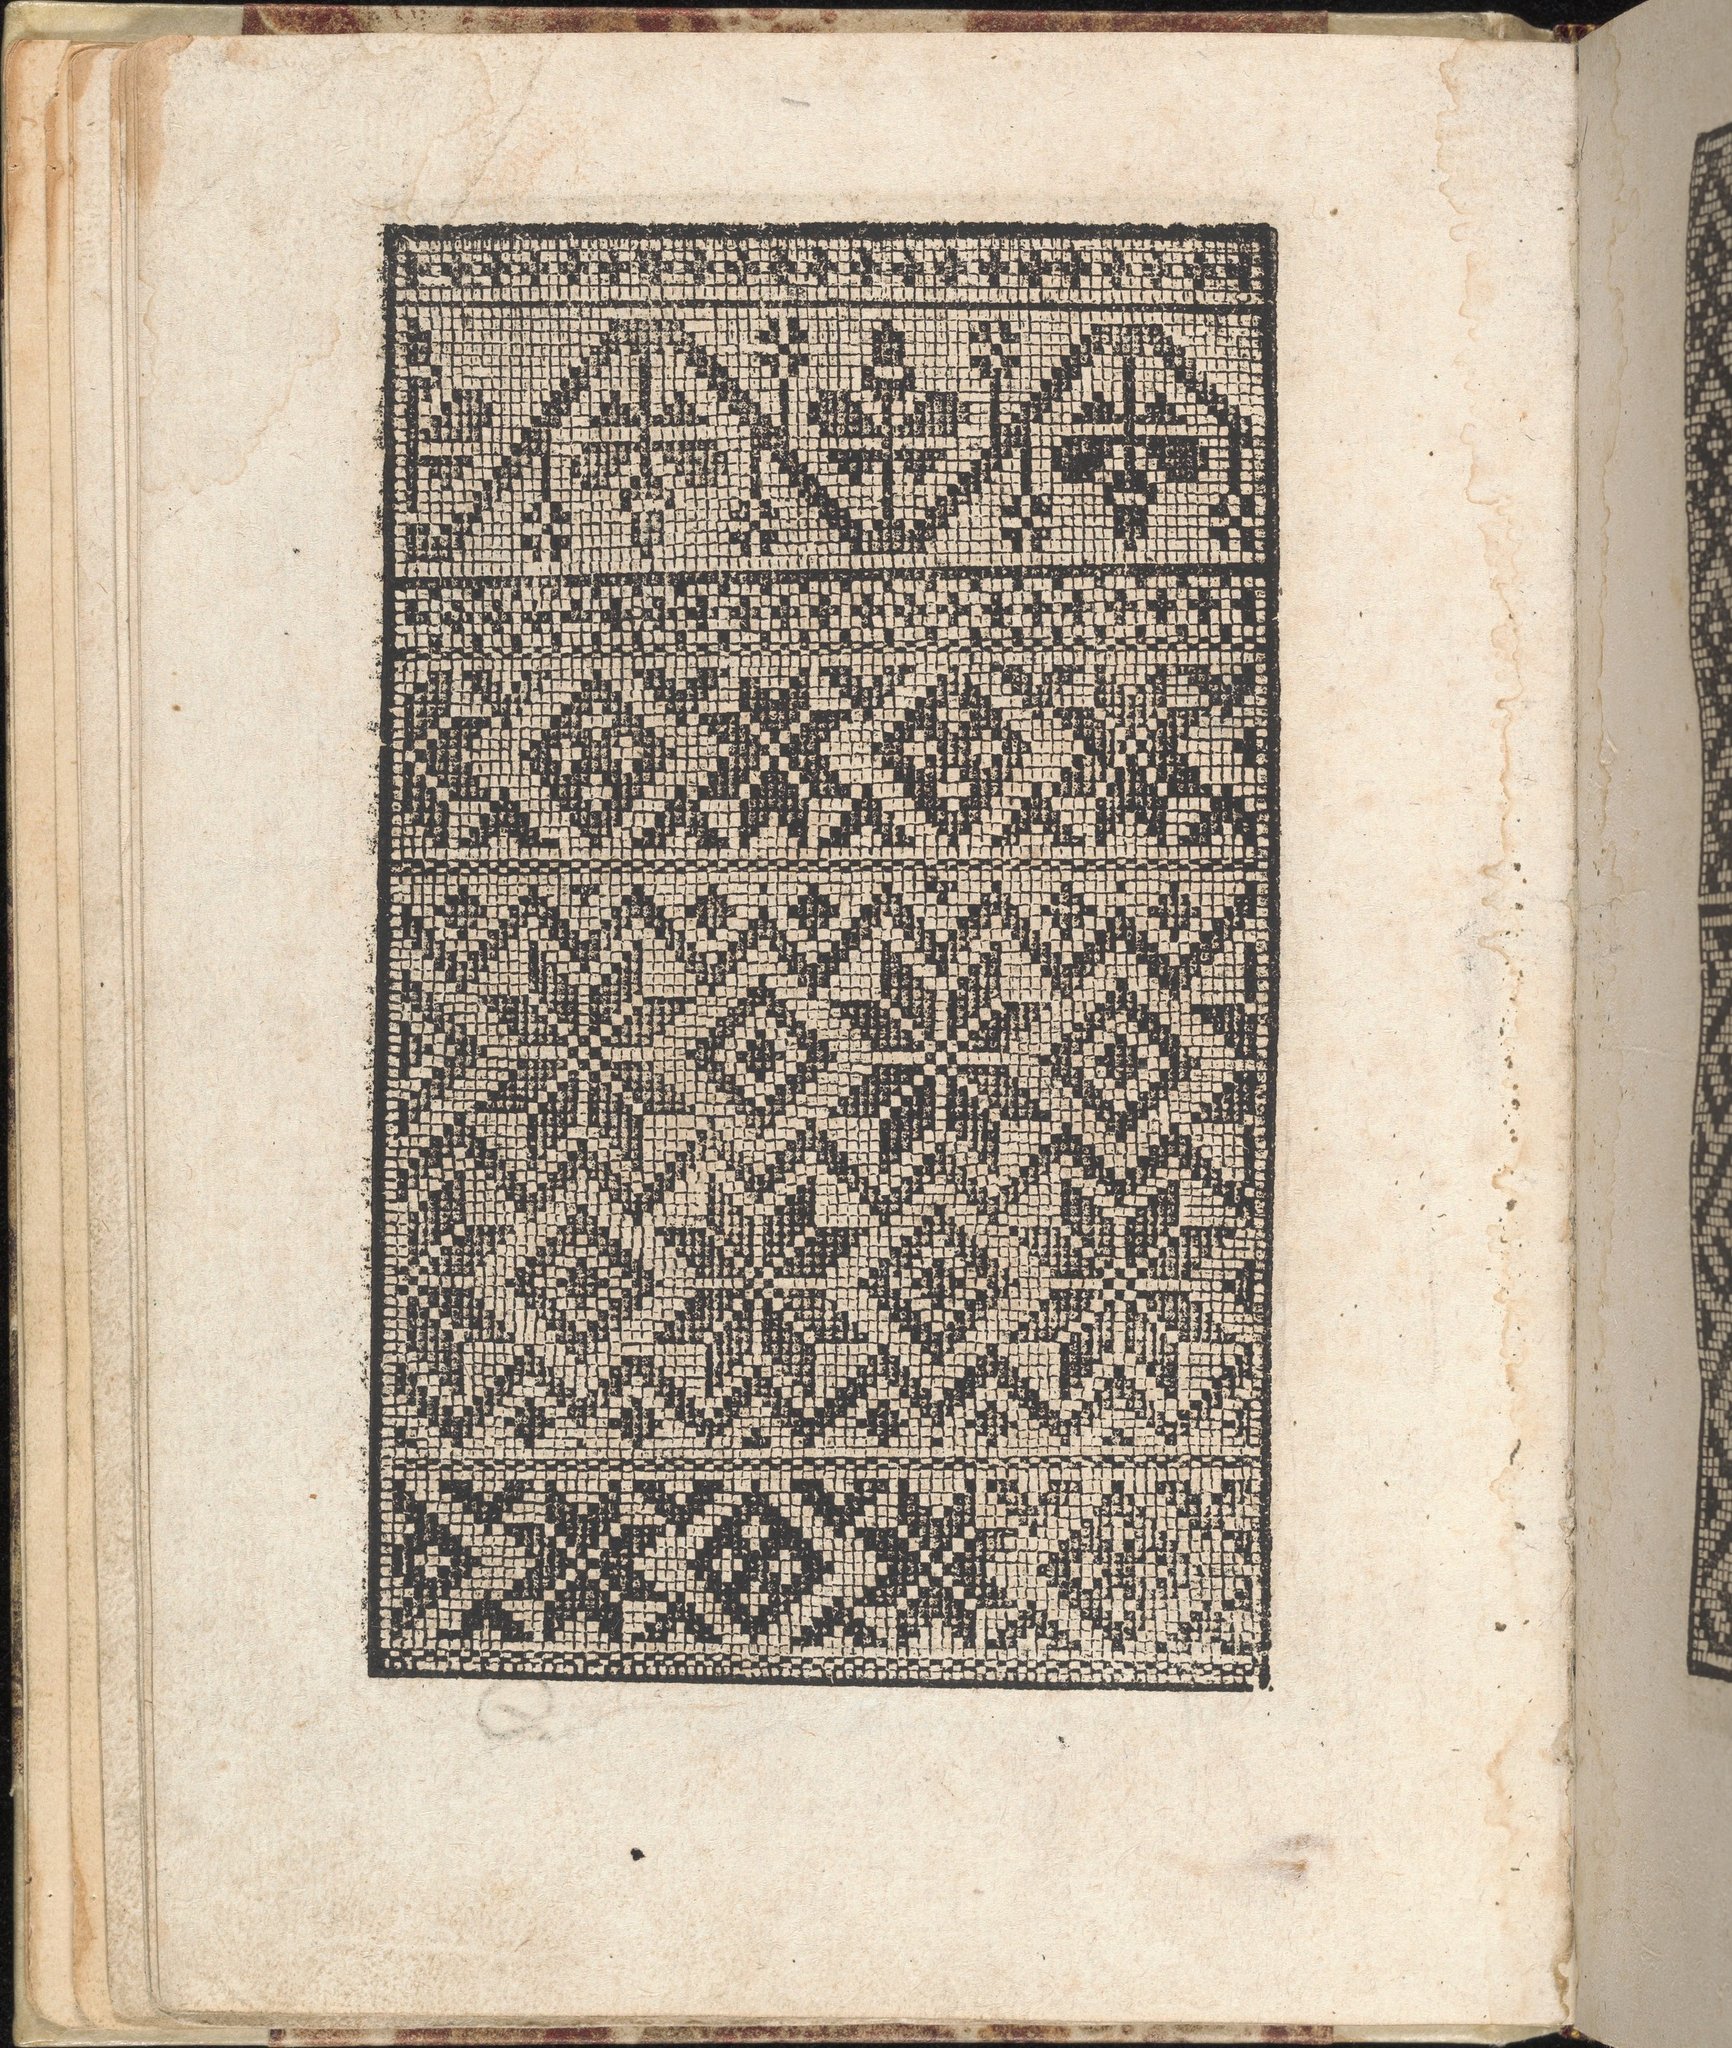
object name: book print ornament architecture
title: Ein new getruckt model Büchli...Page 14, recto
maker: johann schönsperger the younger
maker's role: publisher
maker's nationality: german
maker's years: 1490-1550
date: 1529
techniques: woodcut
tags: ornament